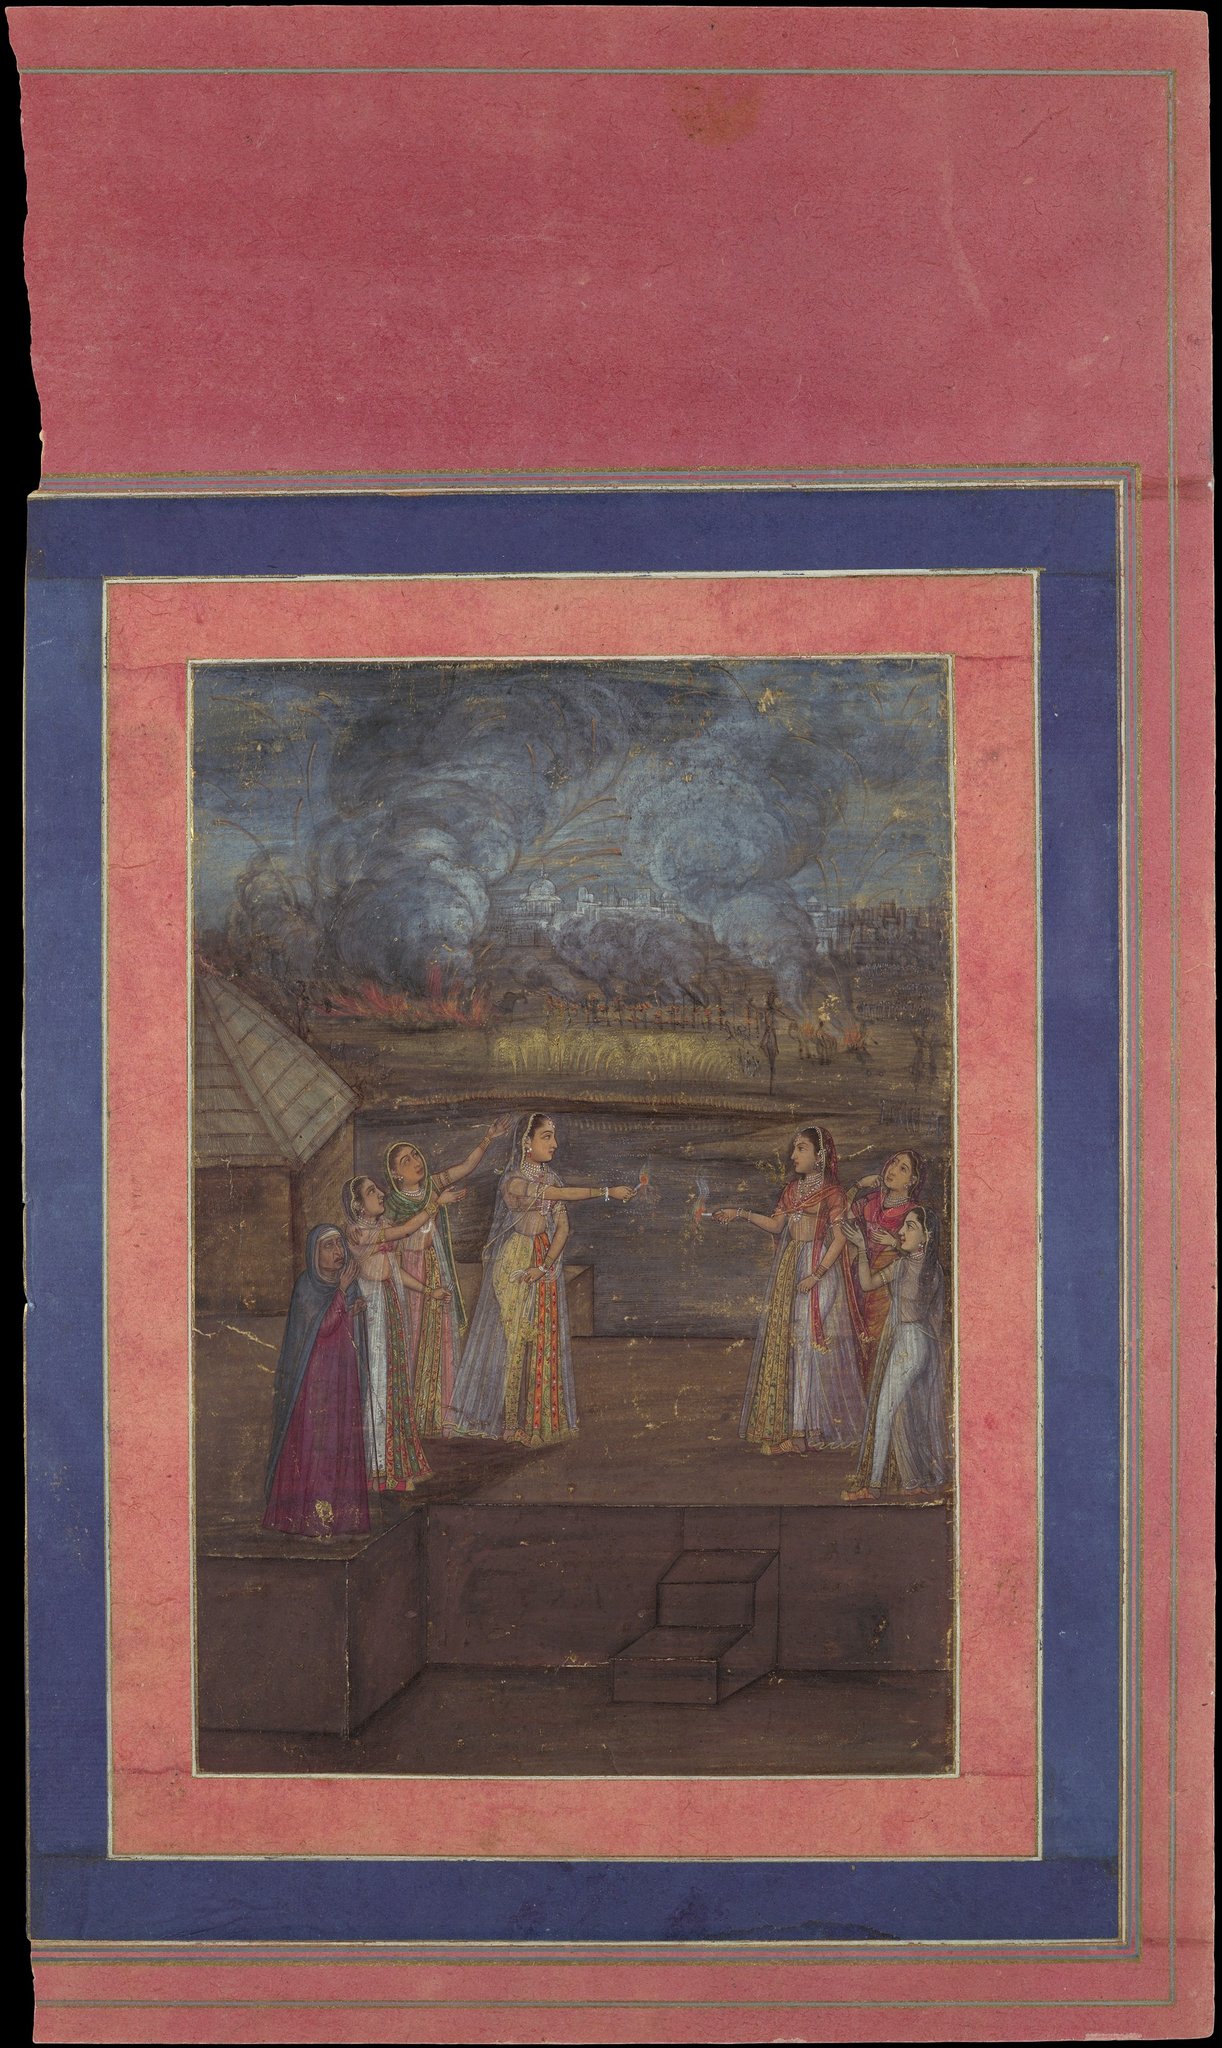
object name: illustrated album leaf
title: "Fireworks on the Night of Shab-i Barat Feast", Folio from the Davis Album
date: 1734-1766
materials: gold, ink, paper, watercolor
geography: india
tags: women,fireworks,night